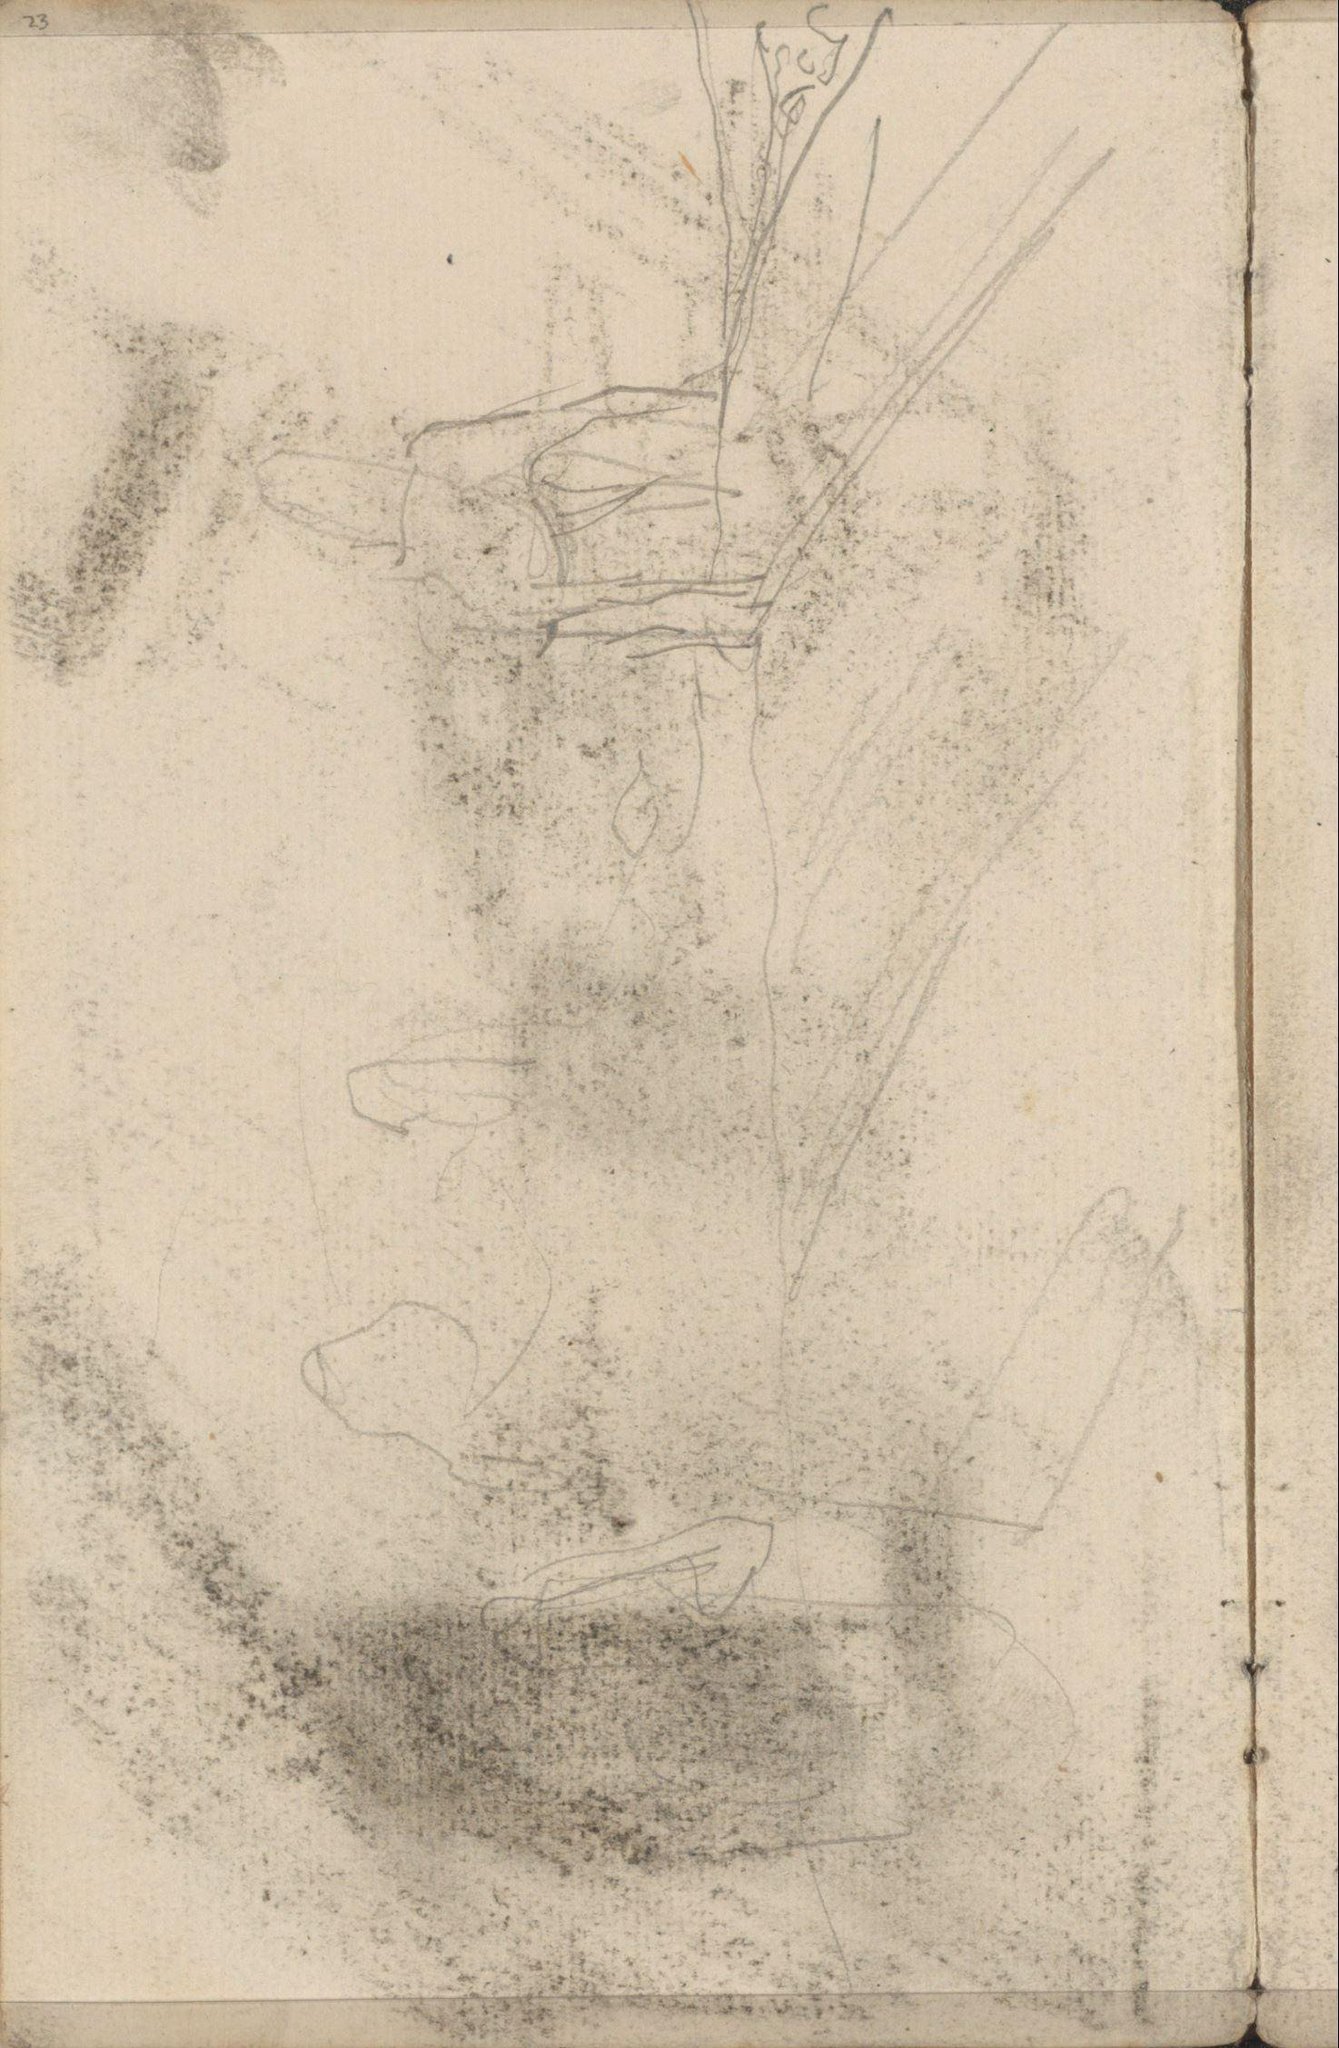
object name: sketchbook leaf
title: Paard en figuren, mogelijk in een landschap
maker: george hendrik breitner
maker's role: draughtsman, painter, print maker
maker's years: 1857-1923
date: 1884-1886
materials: paper, pencil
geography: the hague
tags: horse, landscapes (+ landscape with figures, staffage)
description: Pagina 23 uit een schetsboek met 29 bladen.